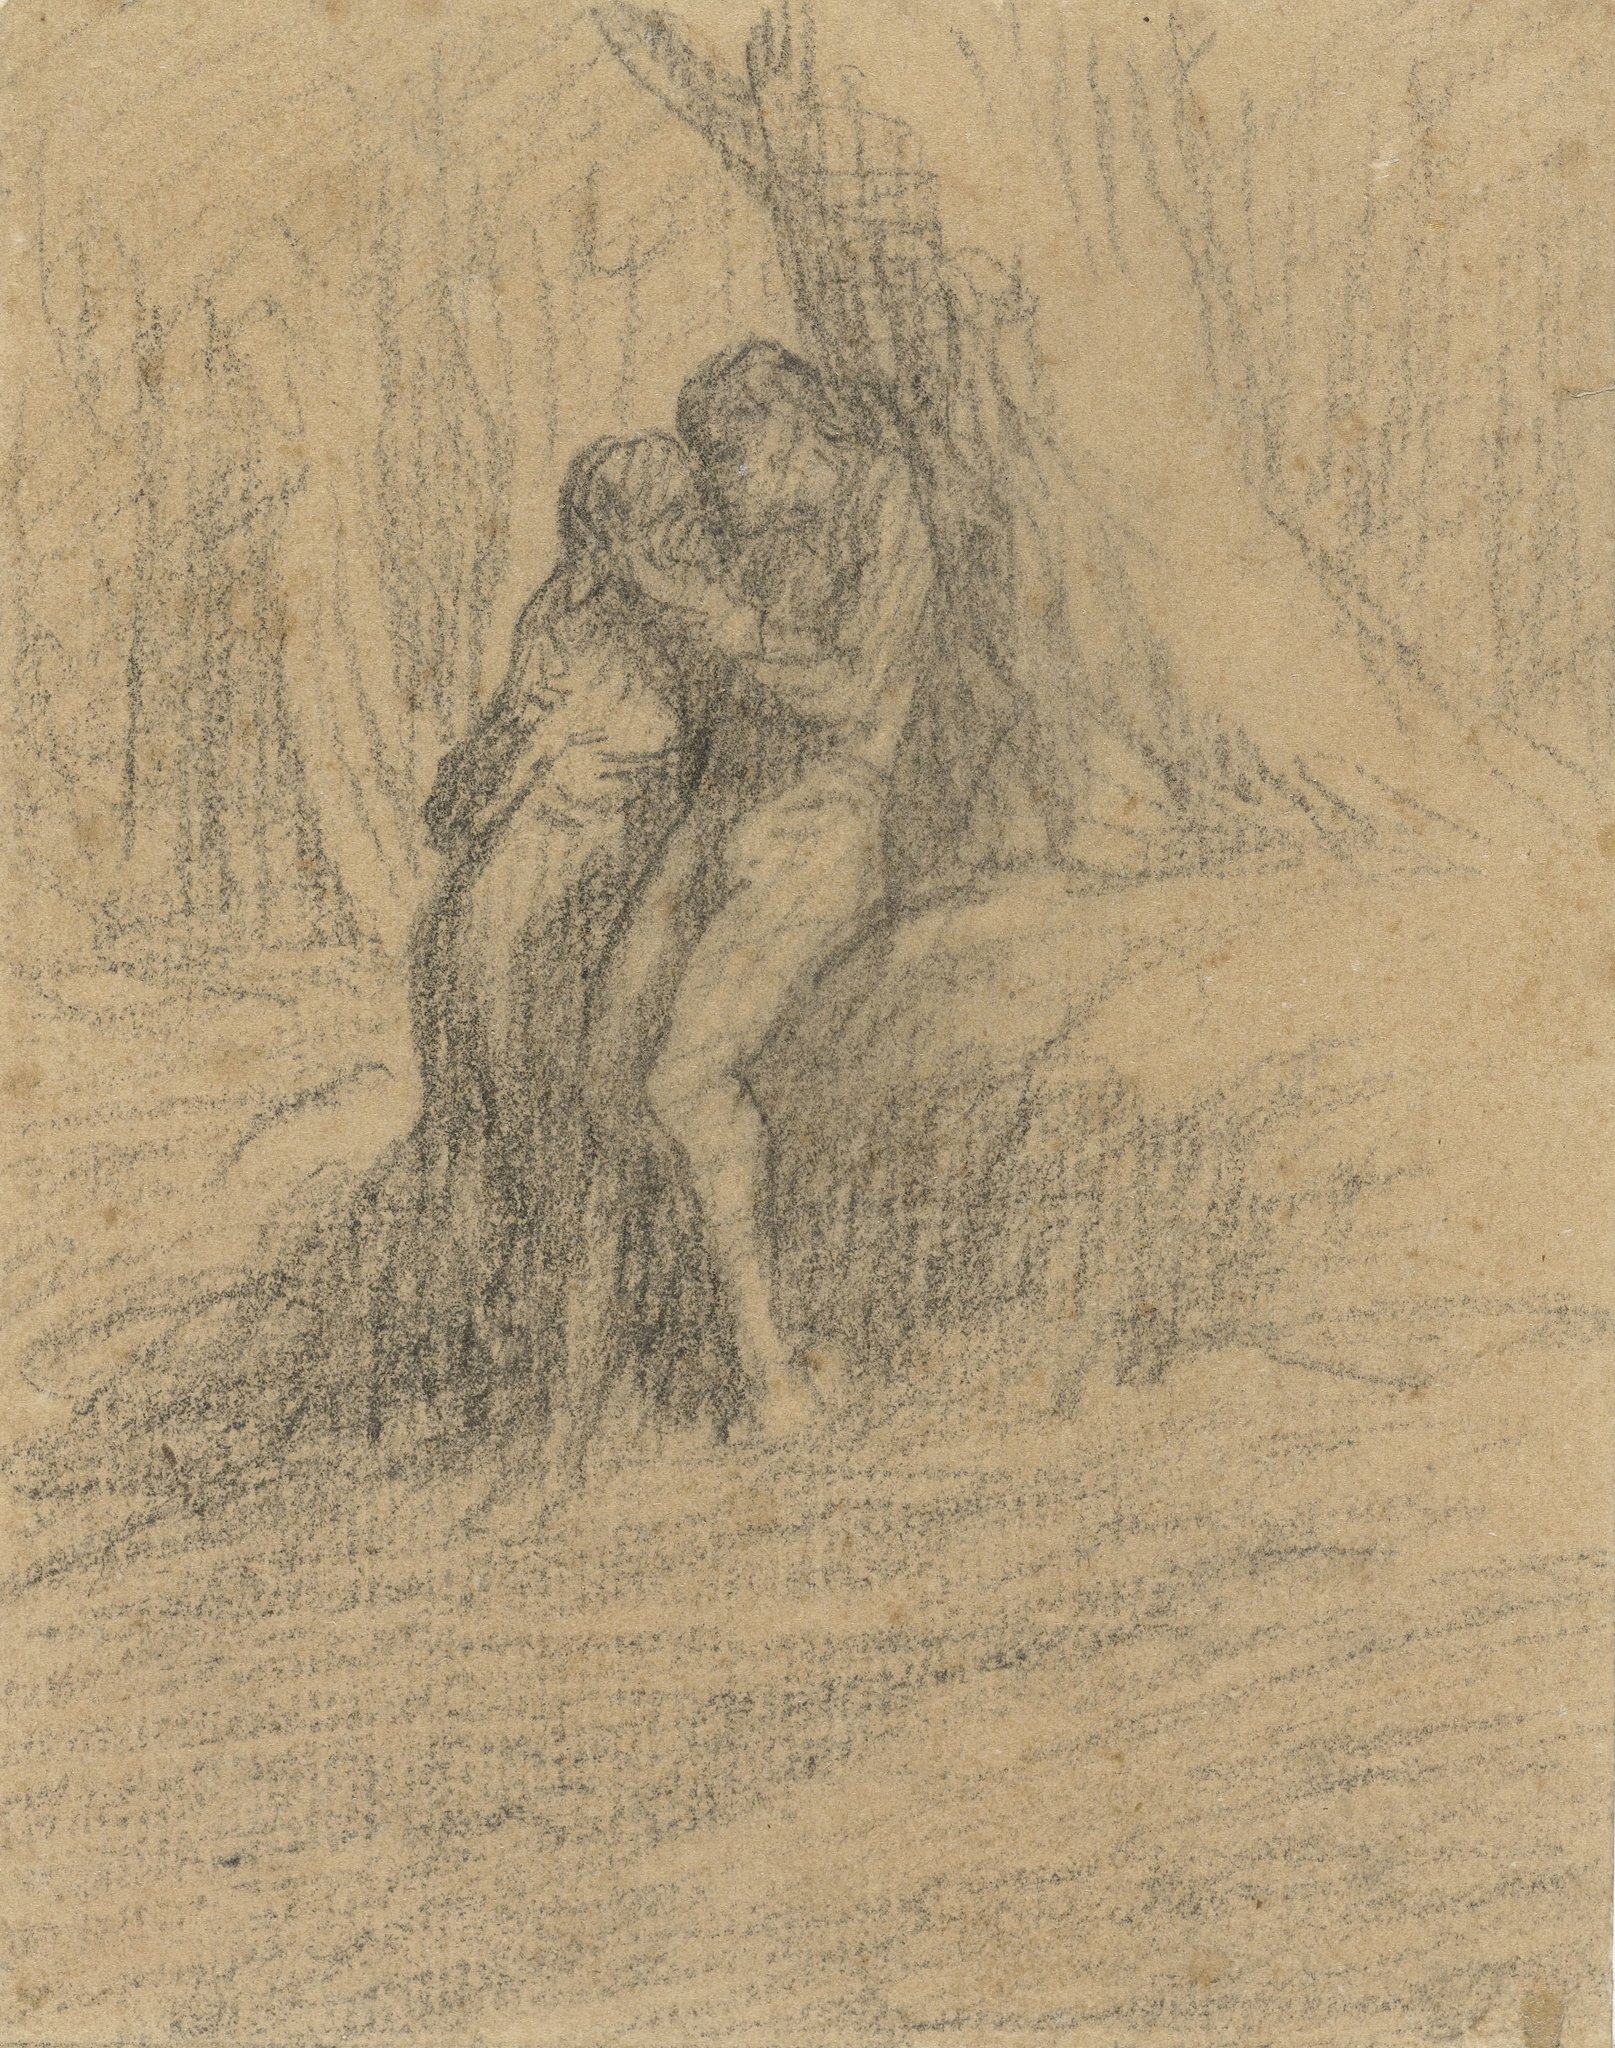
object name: drawing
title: Vrijend boerenpaar onder een zware boom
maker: charles emile jacque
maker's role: draughtsman, painter, print maker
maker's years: 1813-1894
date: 1823-1894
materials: chalk, paper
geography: france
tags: (lovers) kissing each other